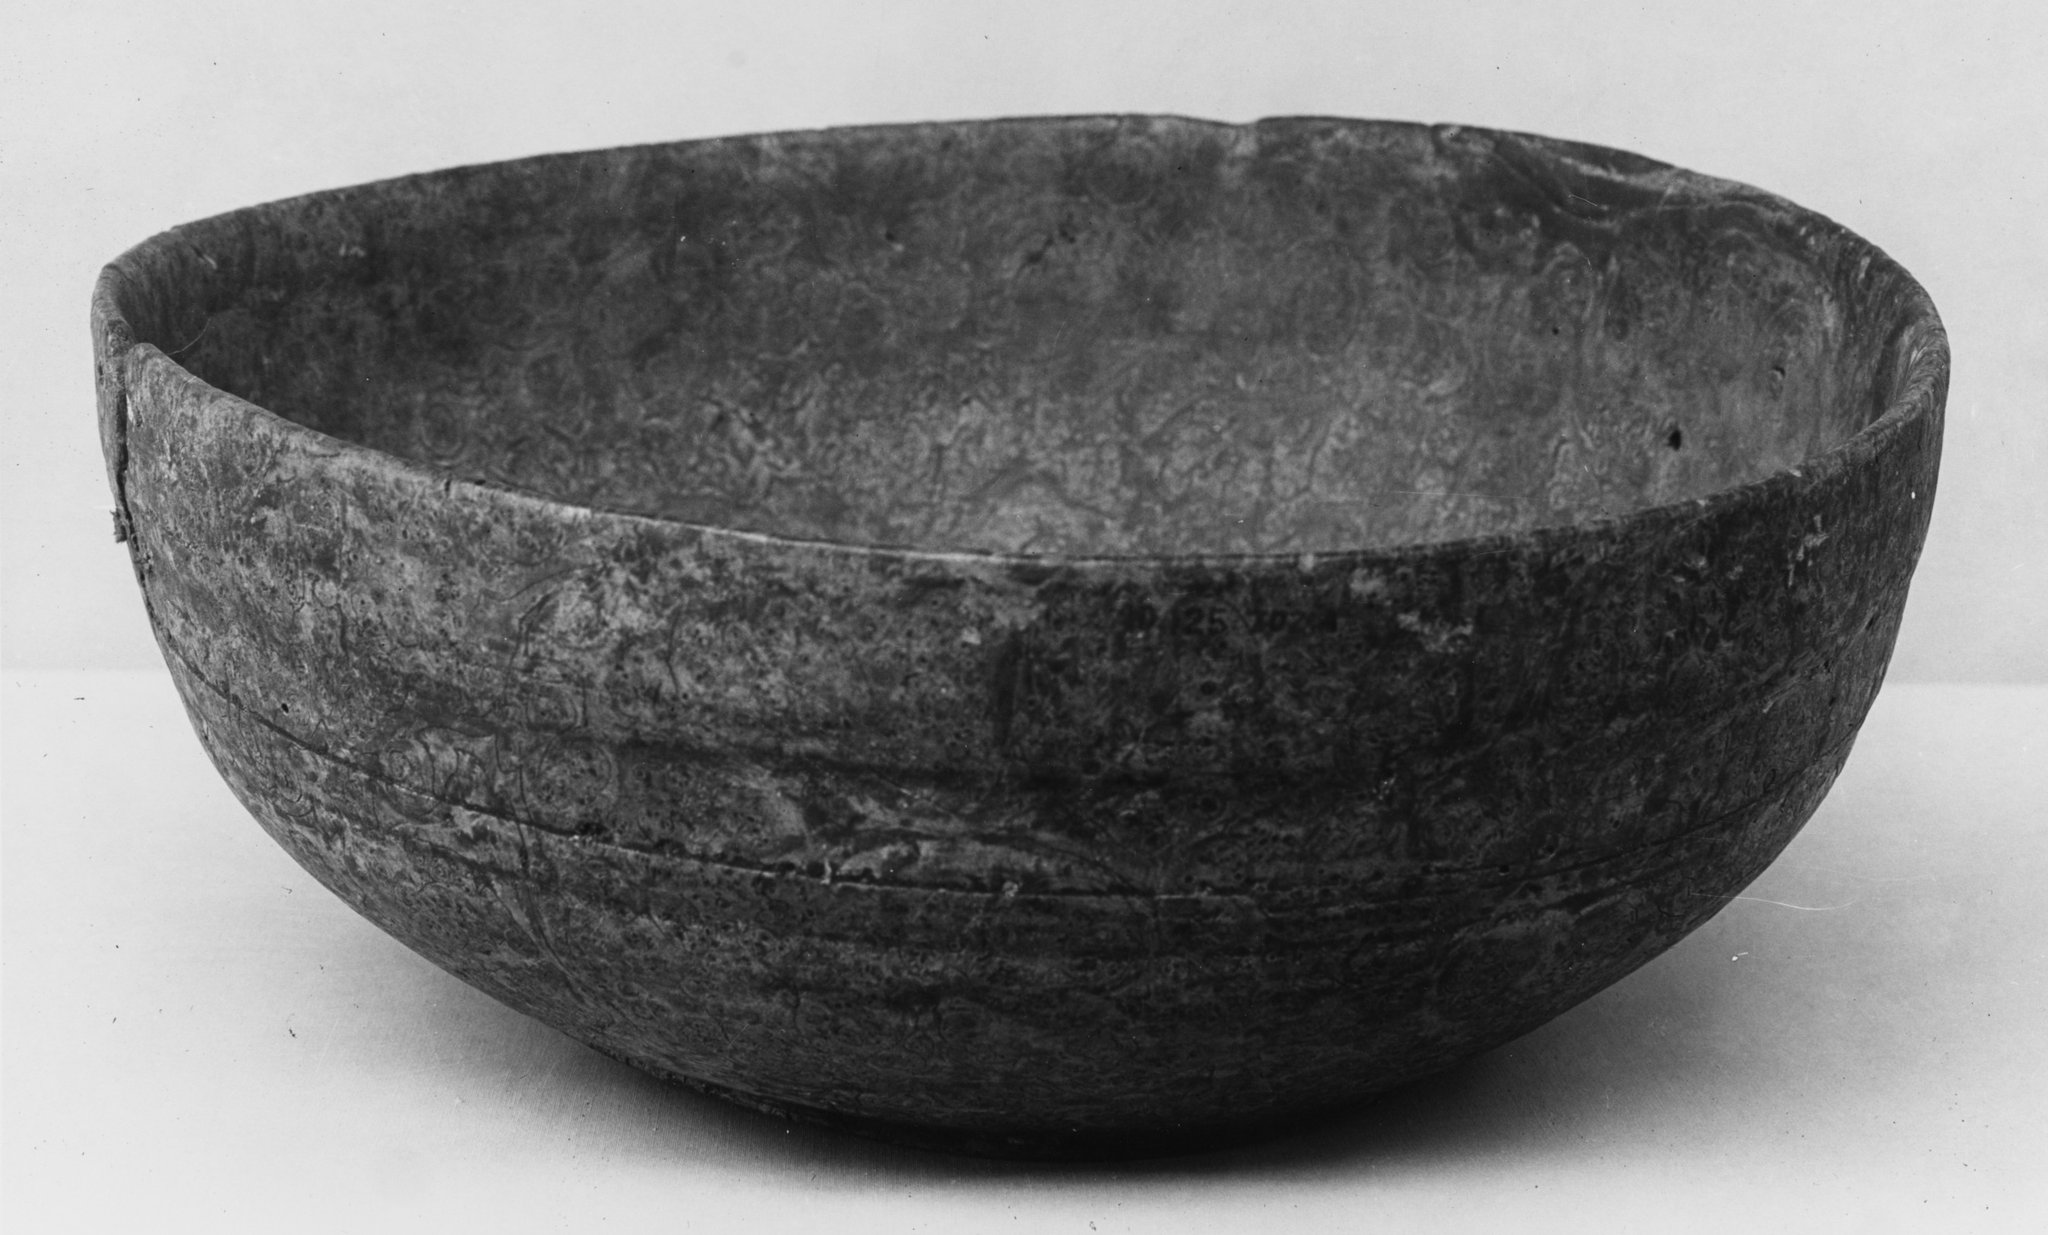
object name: bowl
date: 1670-1730